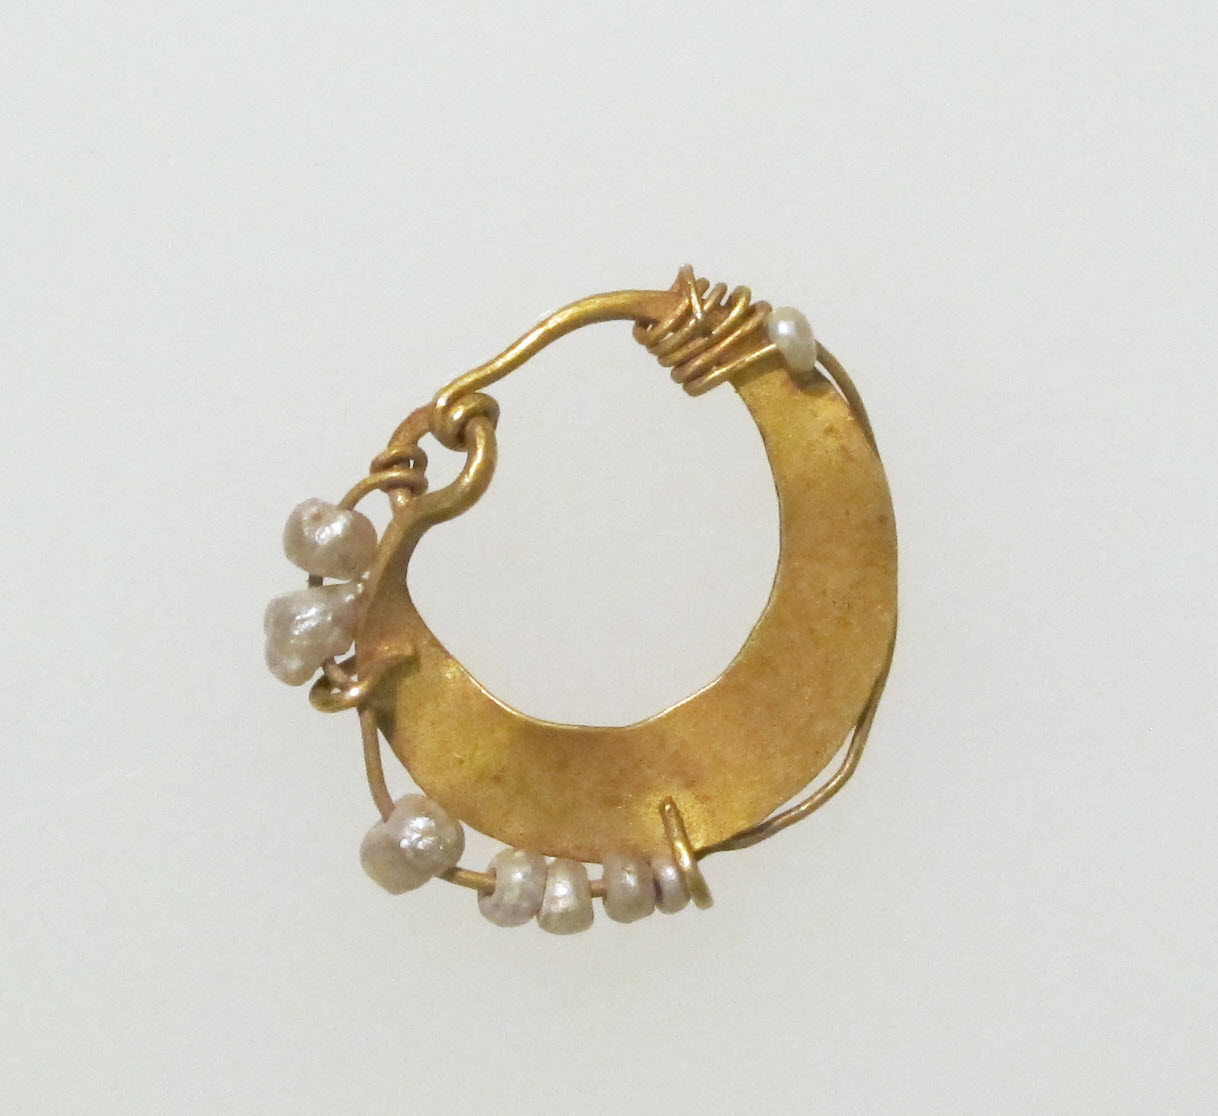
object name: earring, crescent shaped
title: Earring, crescent-shaped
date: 7000 BCE-330 CE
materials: gold